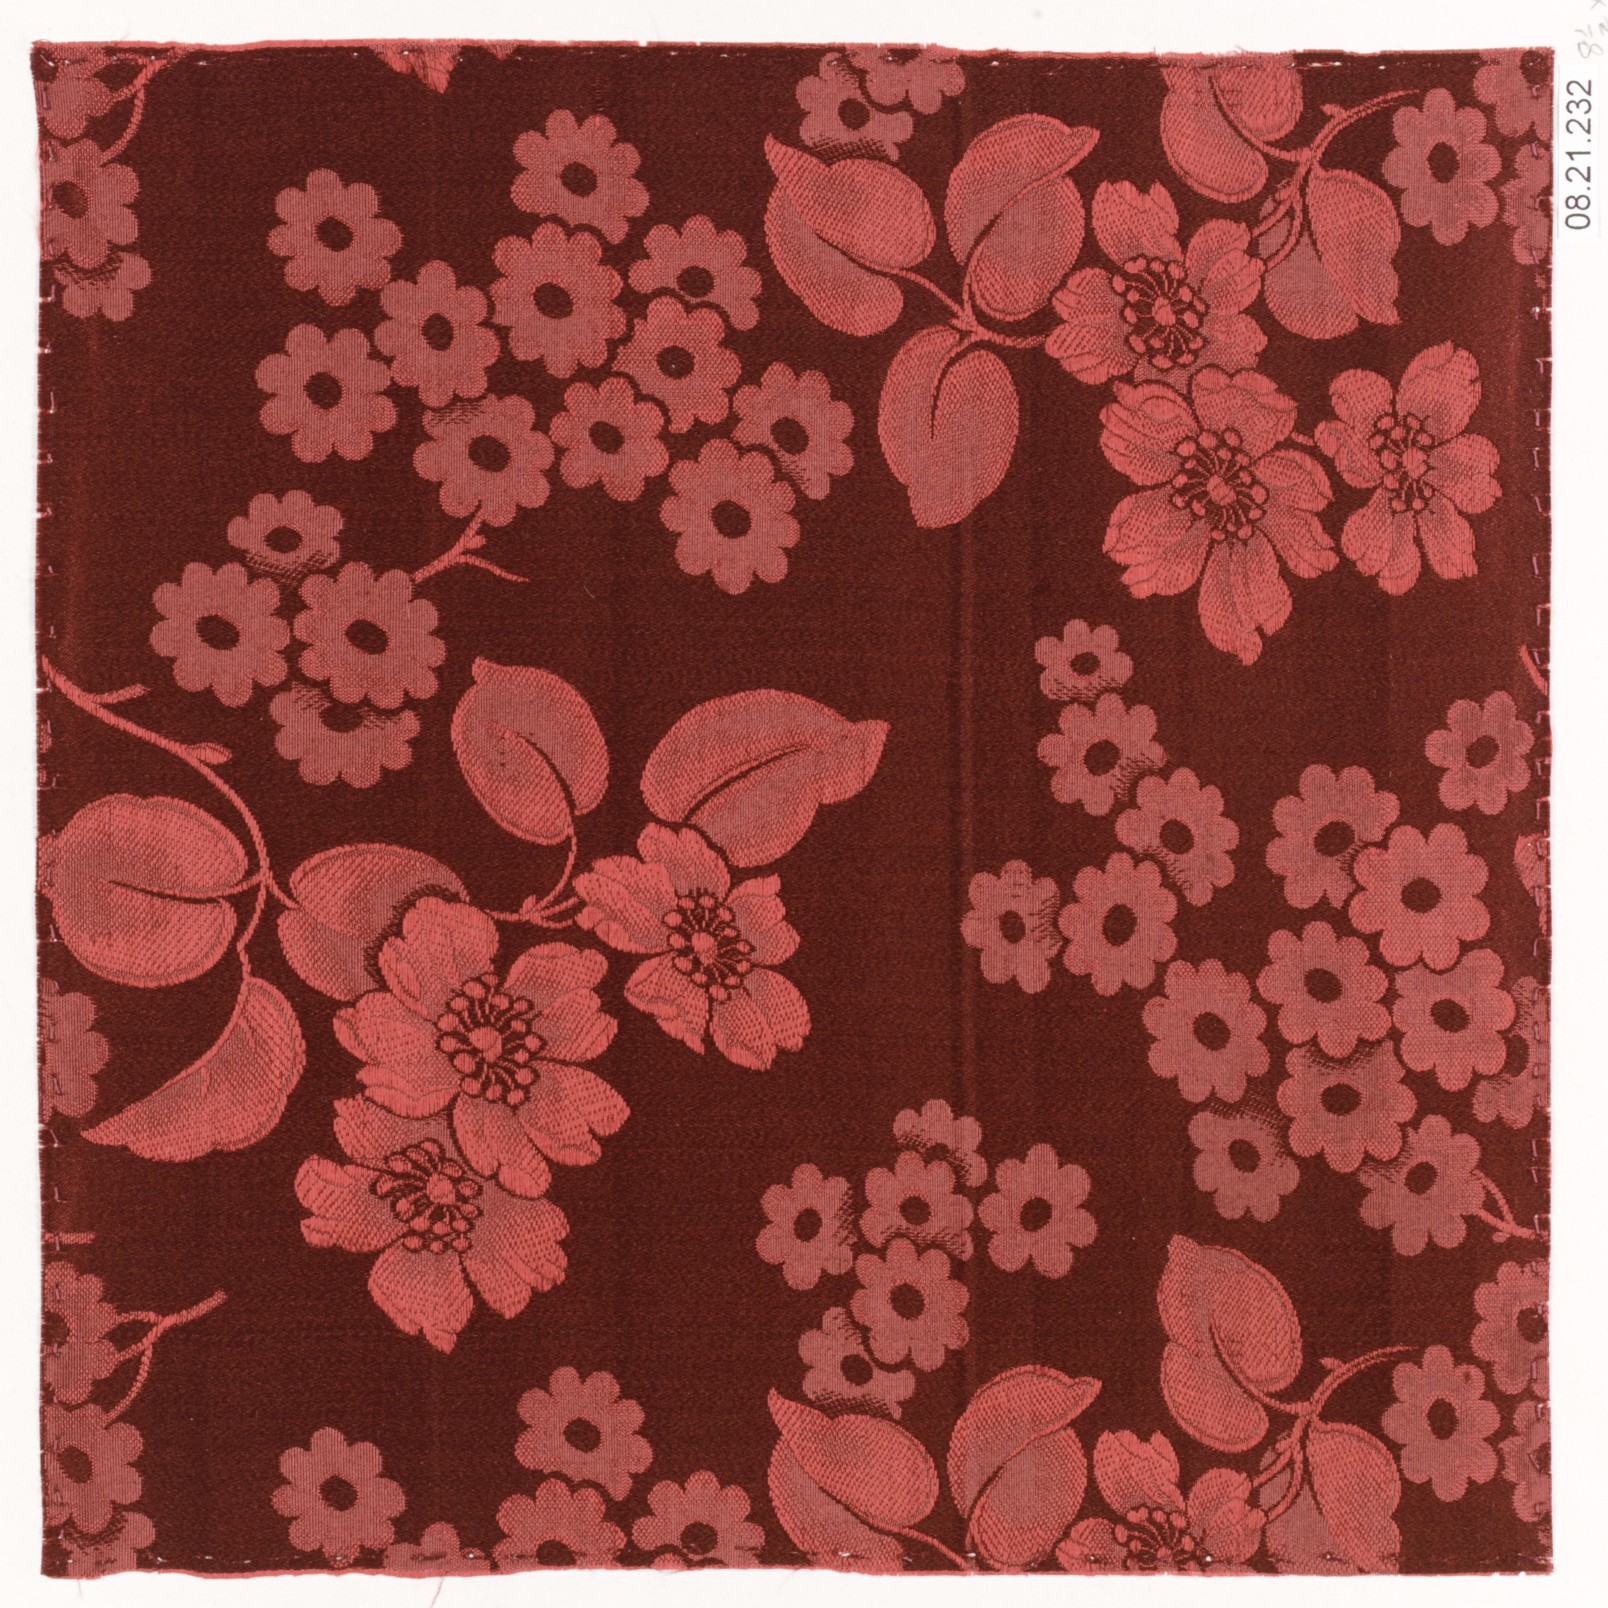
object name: textile sample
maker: Anonymous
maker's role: designer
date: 1900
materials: silk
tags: flowers